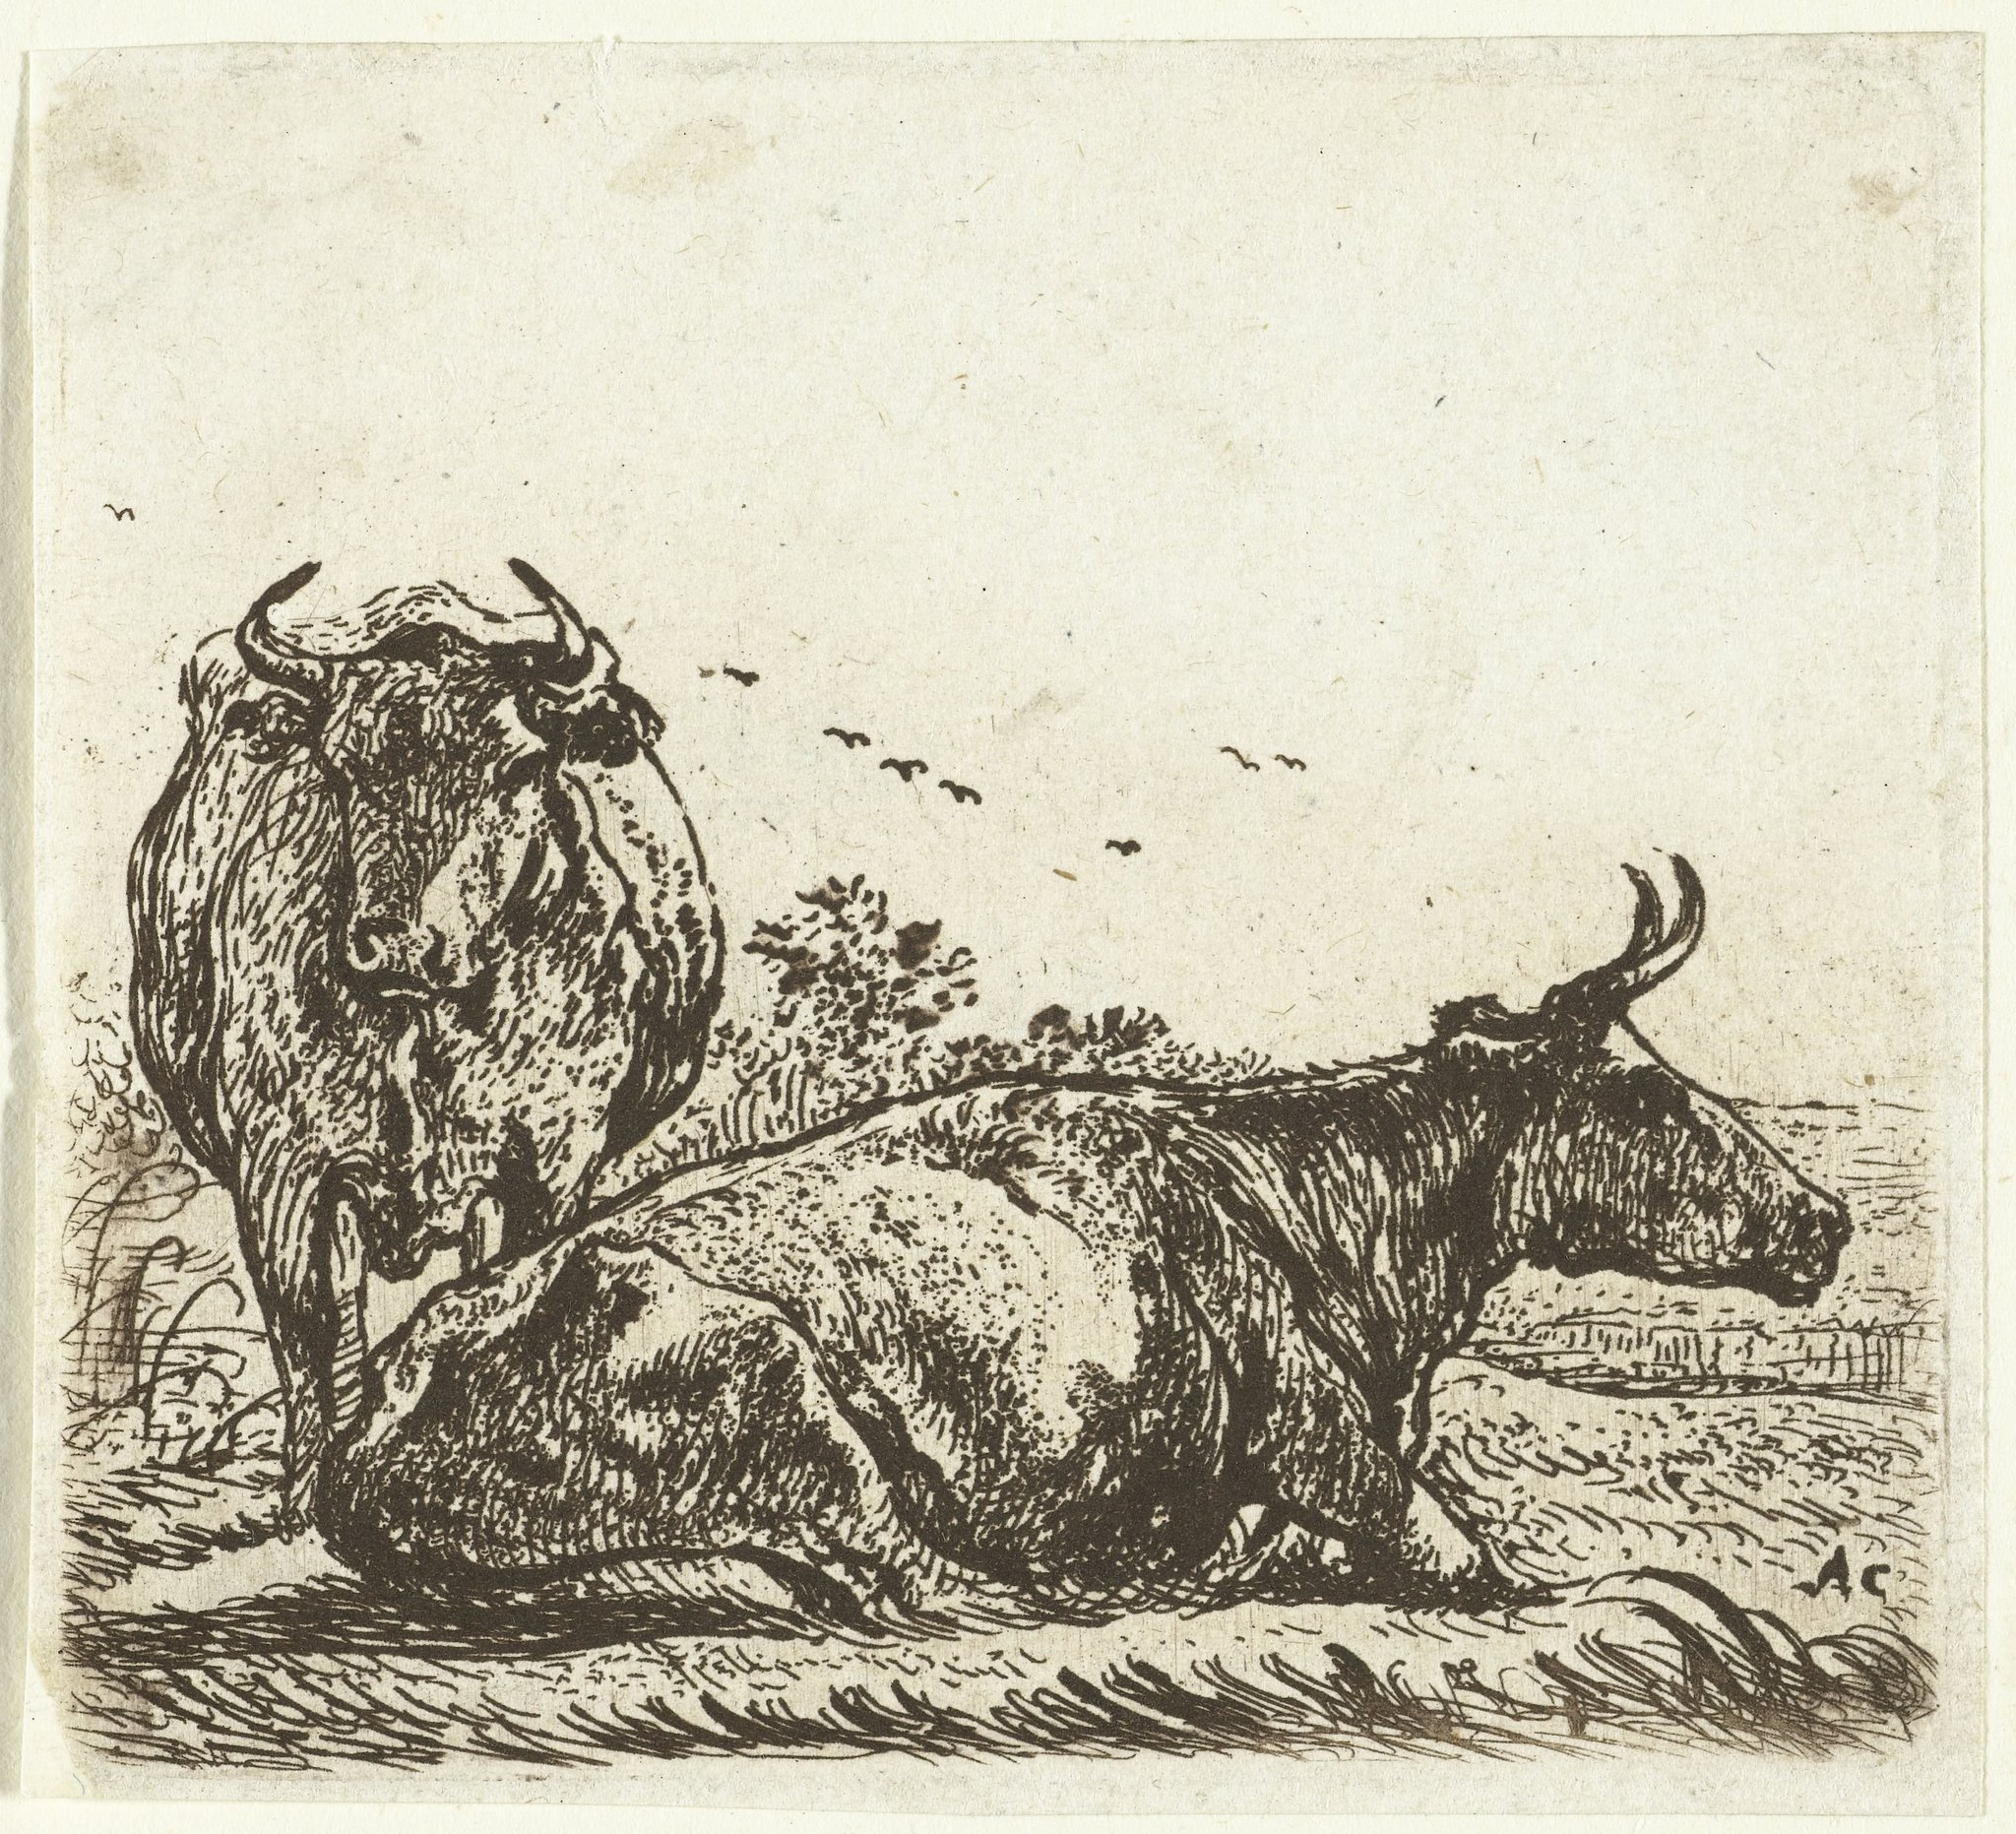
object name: print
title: Twee koeien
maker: aelbert cuyp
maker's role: draughtsman, painter, print maker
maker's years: 1620-1691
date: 1630-1691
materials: paper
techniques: etching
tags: cow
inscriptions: collector's mark: Lugt 2760, collector's mark: Lugt 2228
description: Prent uit serie van zes prenten met koeien.